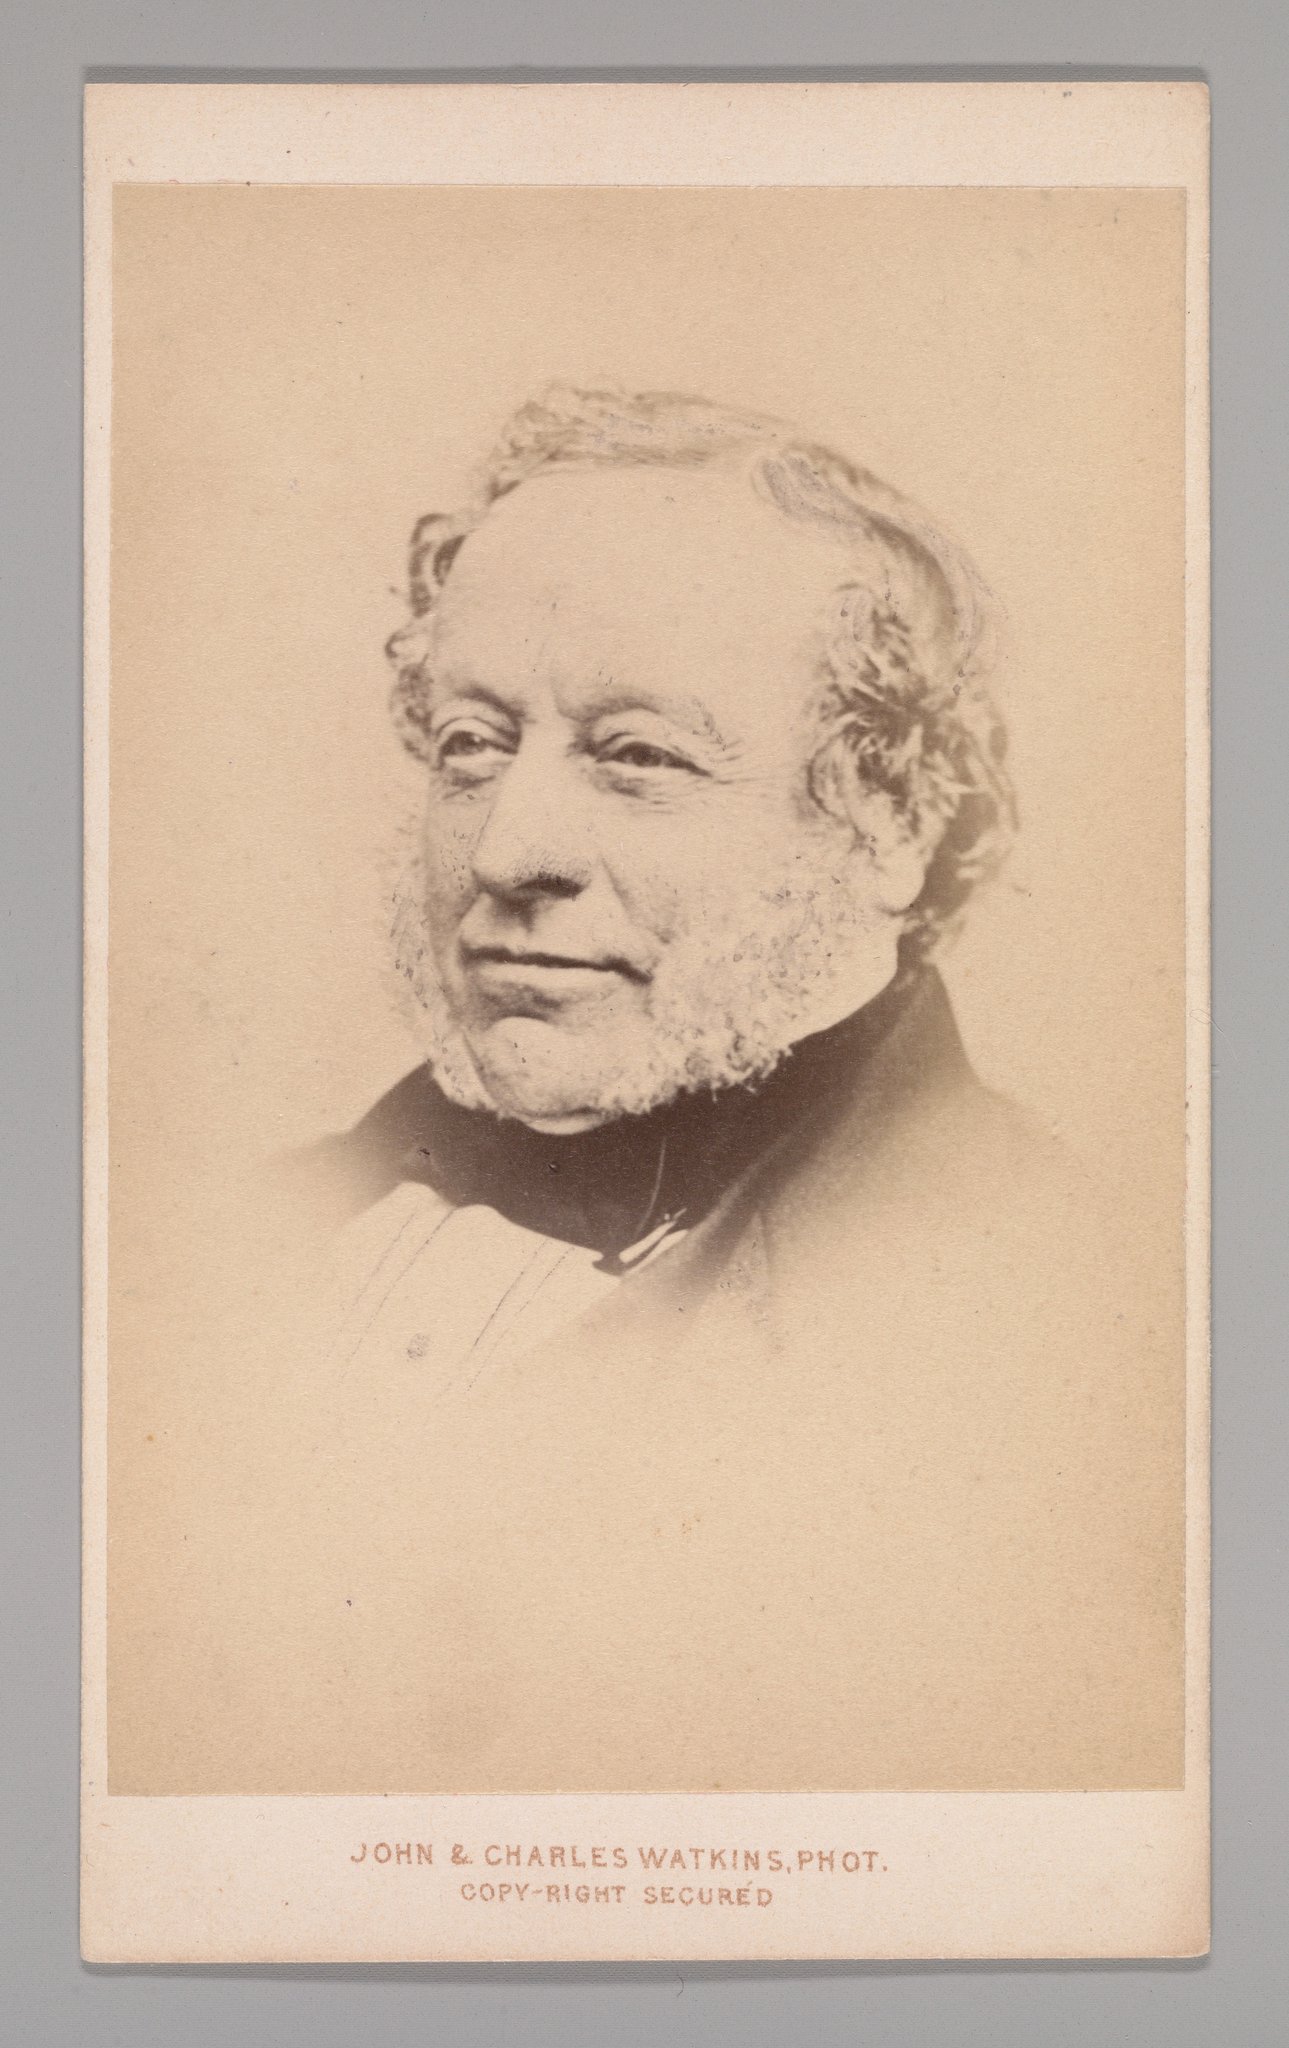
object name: carte de visite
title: [Sir Charles Barry]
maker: john and charles watkins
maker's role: photography studio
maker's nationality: british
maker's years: 1840-1875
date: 1860-1869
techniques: albumen silver print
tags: men,portraits